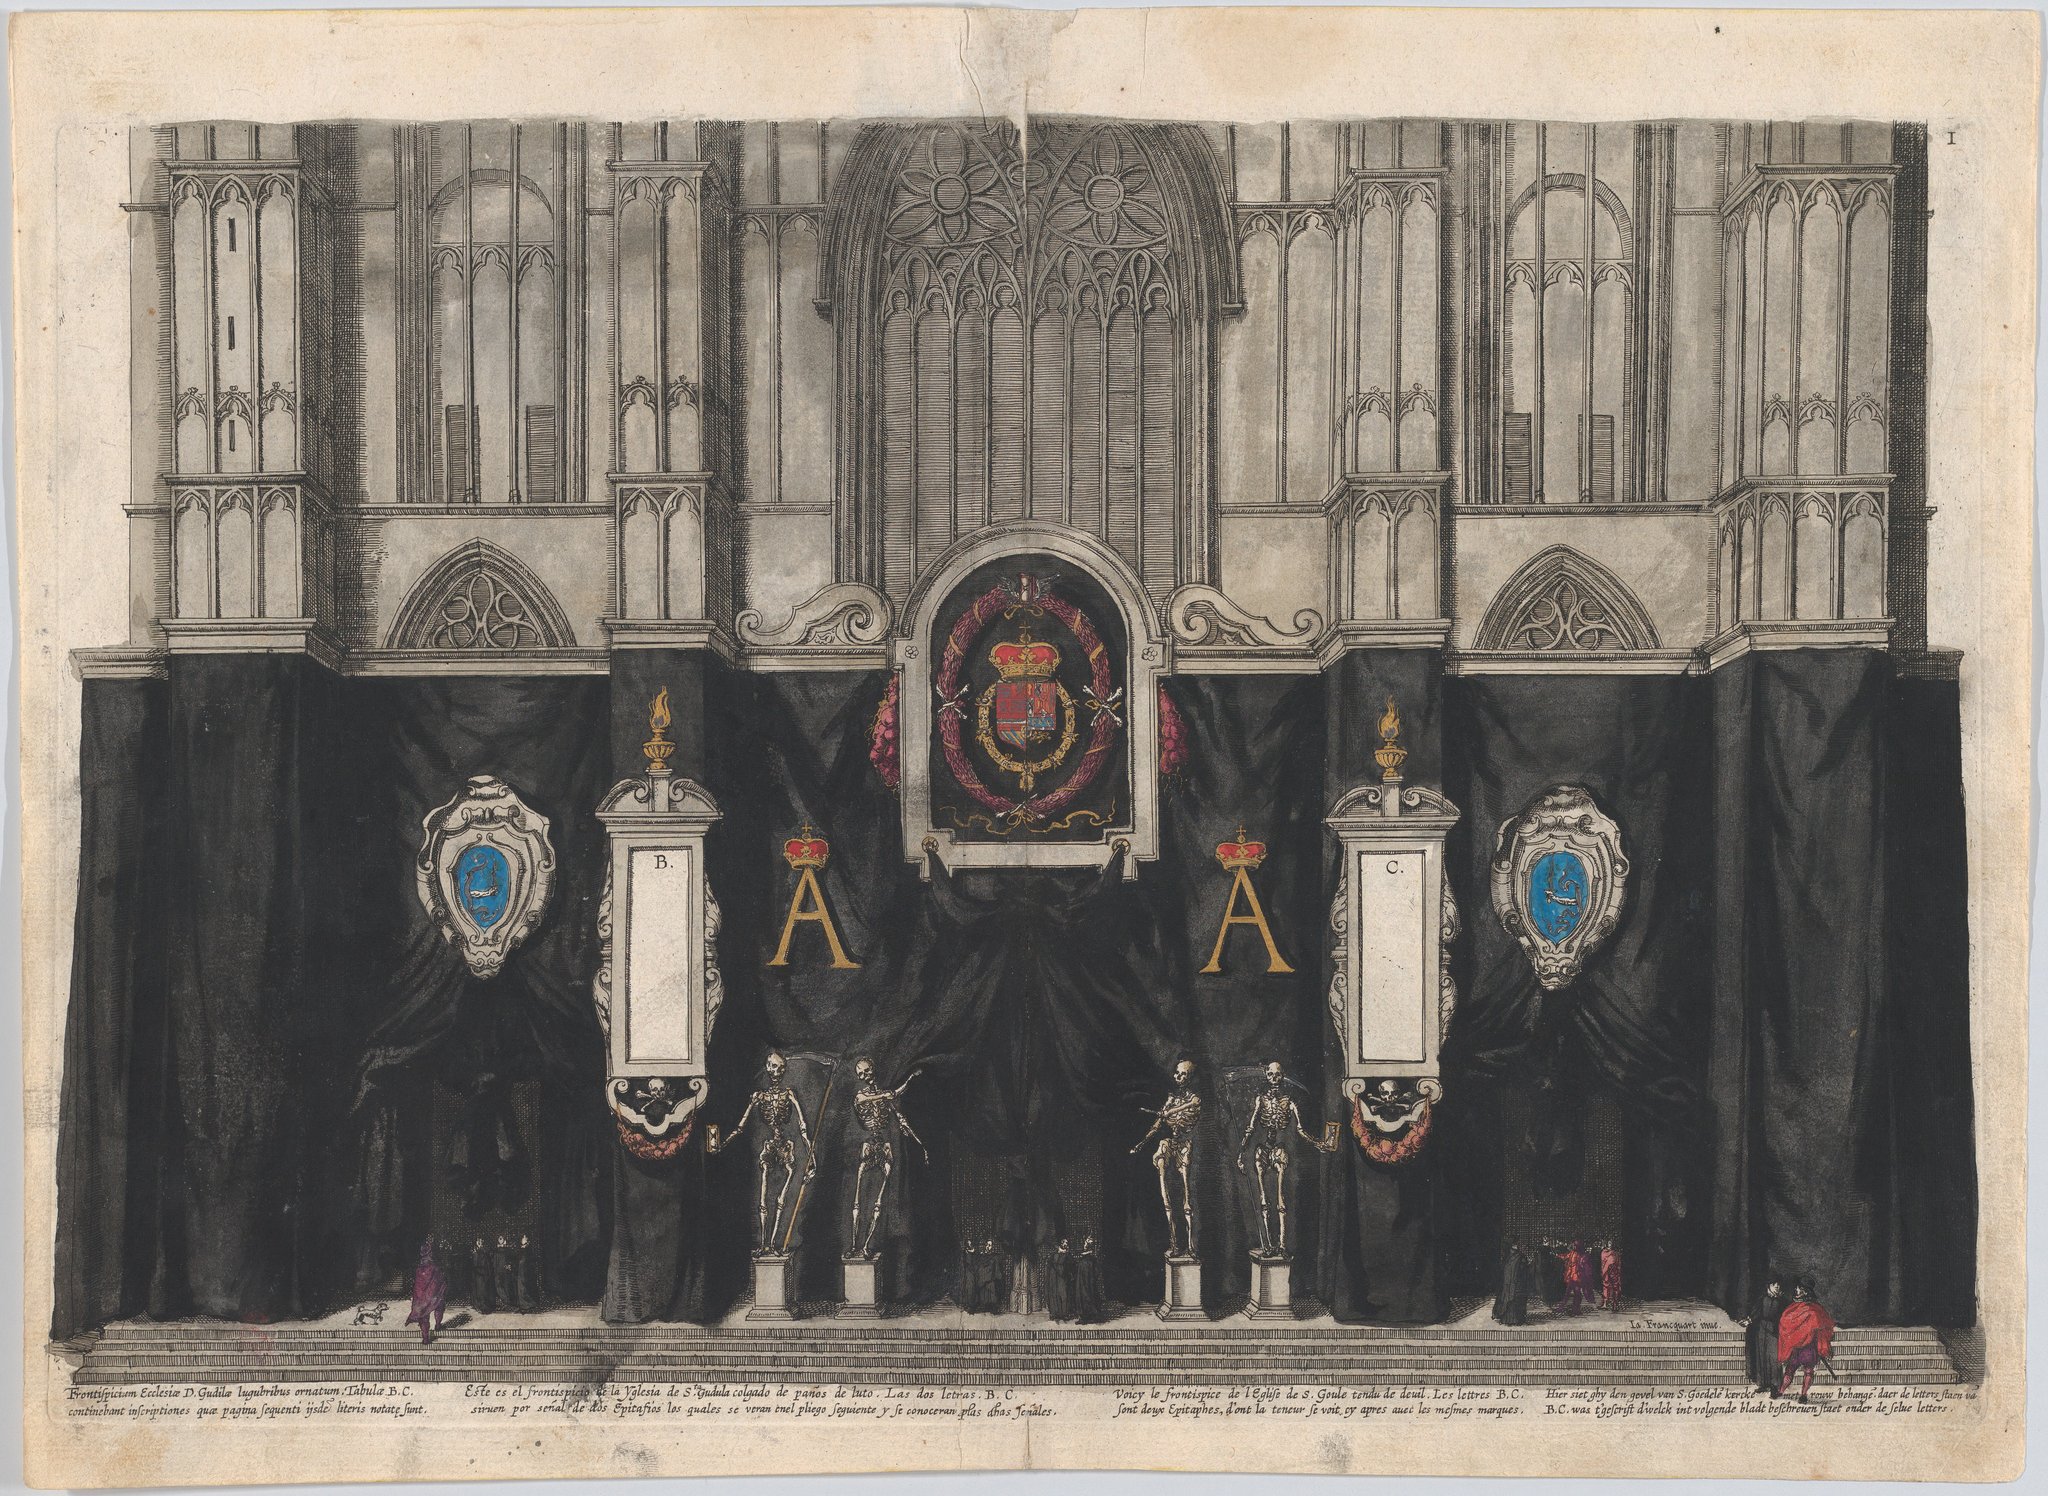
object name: print, fete, ornament architecture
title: Plate 1: Figures gathered before a curtained wall, decorated with three armorials with the coat of arms and symbols celebrating Archduke Albert, four skeletons on pedestals at center, gothic facade in background; from 'Pompa Funebris ... Alberti Pii'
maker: cornelis galle (i)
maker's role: artist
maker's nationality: netherlandish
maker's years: 1576-1650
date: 1623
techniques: etching, hand coloring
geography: brussels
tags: skeletons,coat of arms,insignia